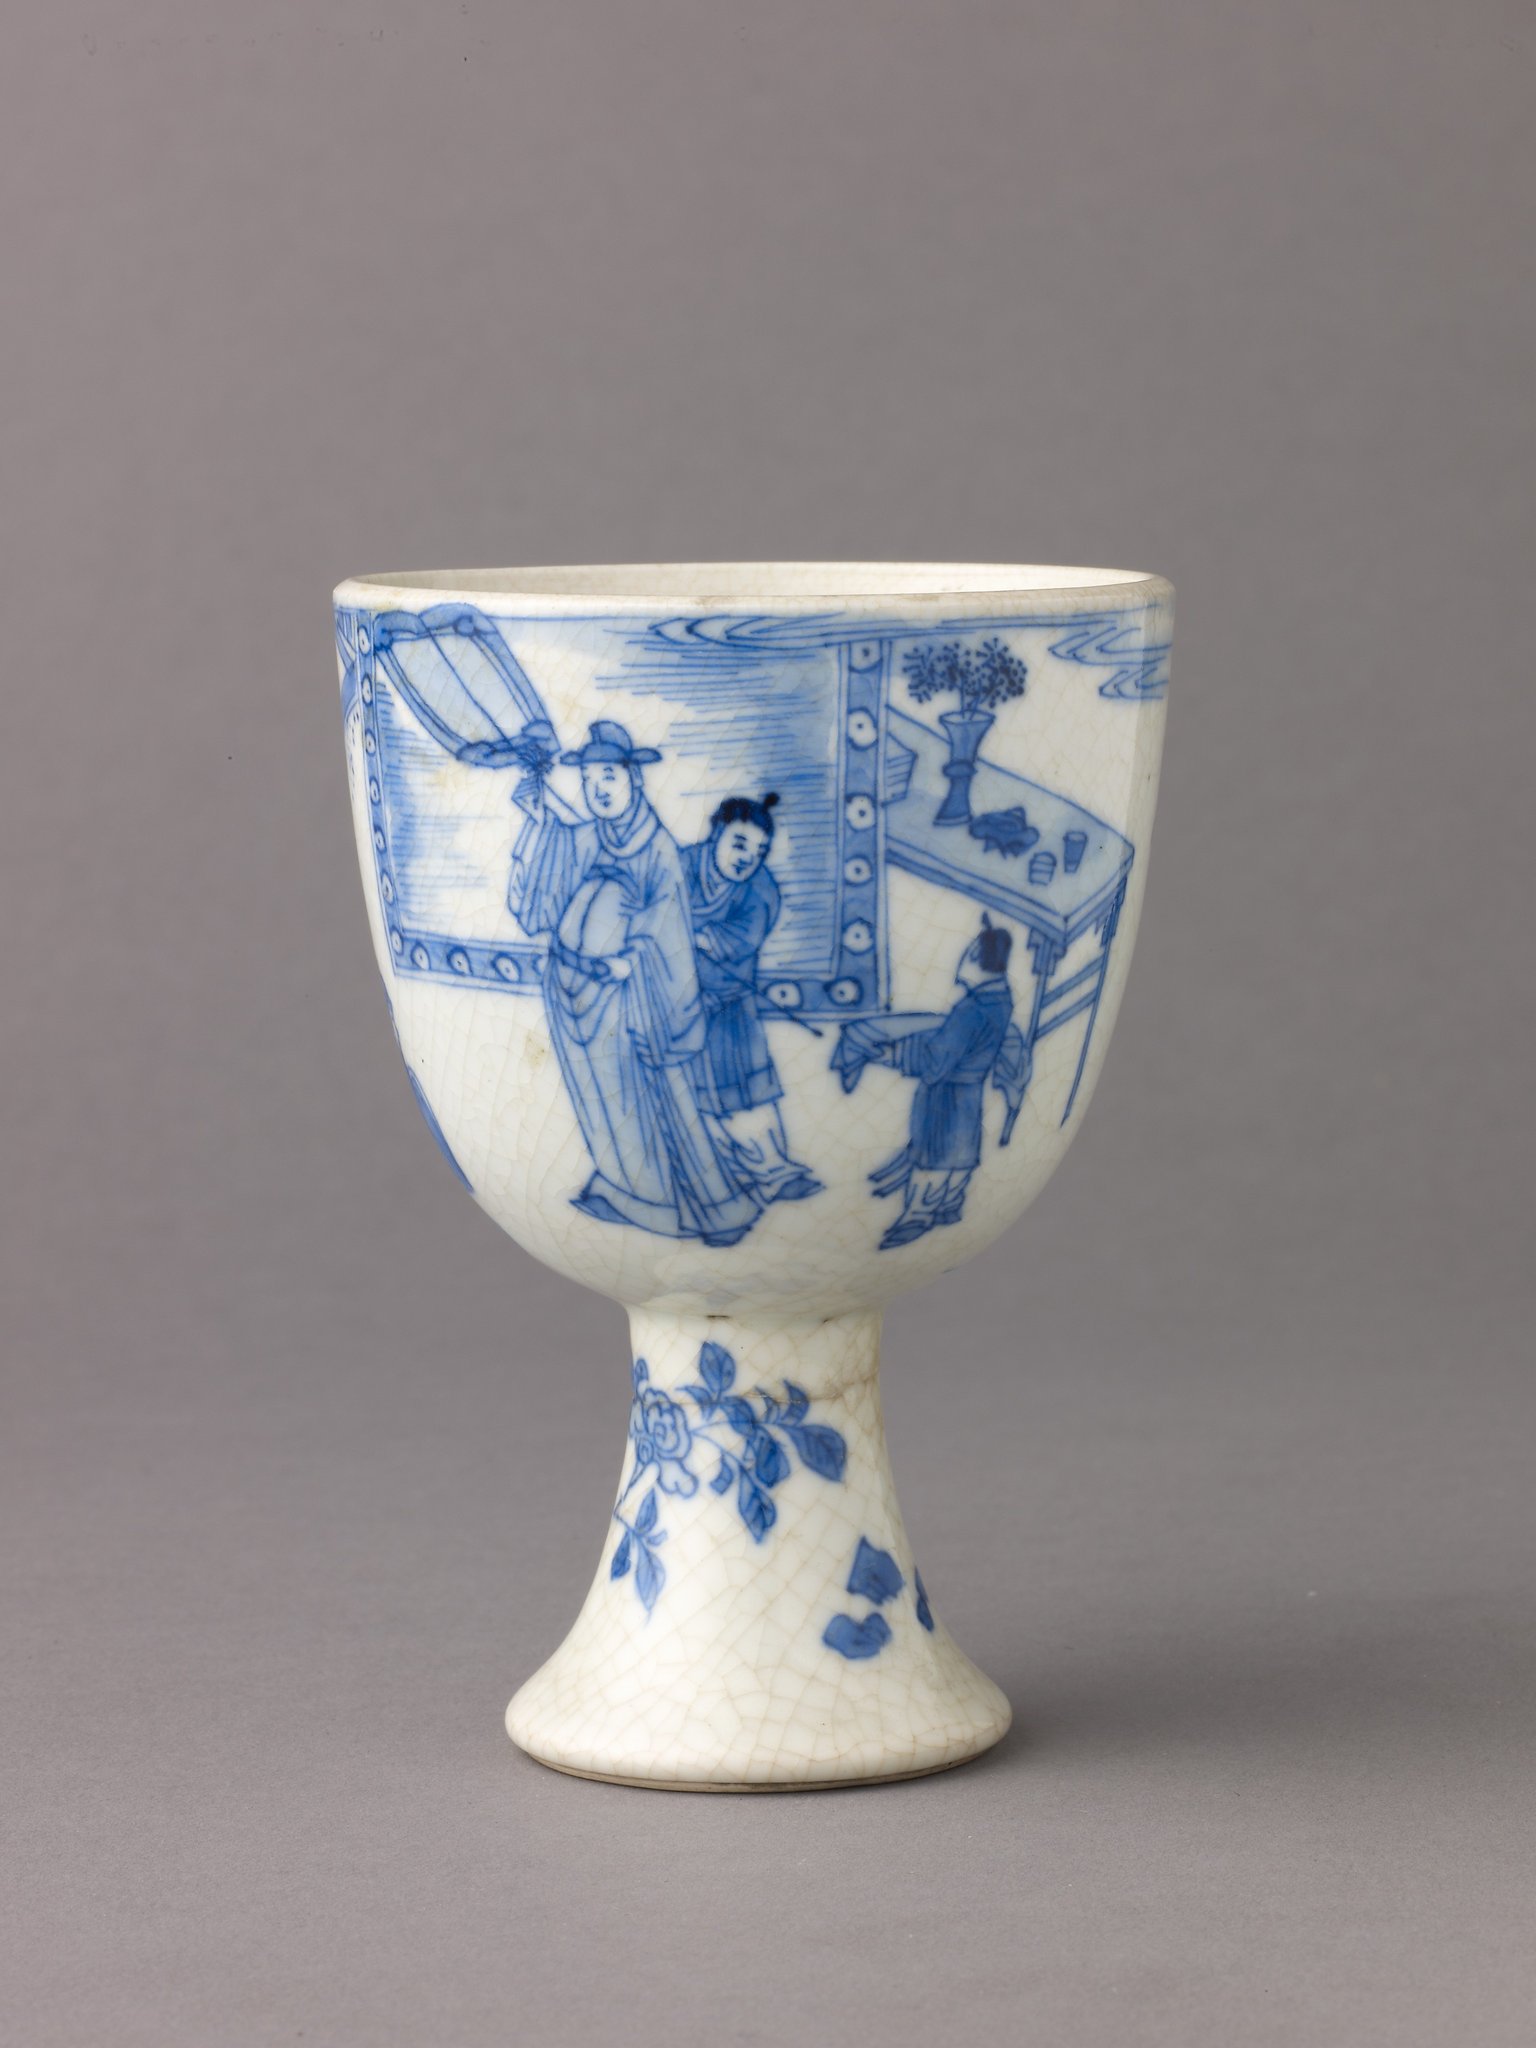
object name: cup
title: Small stemcup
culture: chinese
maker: chinese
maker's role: artist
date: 1651-1700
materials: paste, porcelain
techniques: painting, underglaze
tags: men